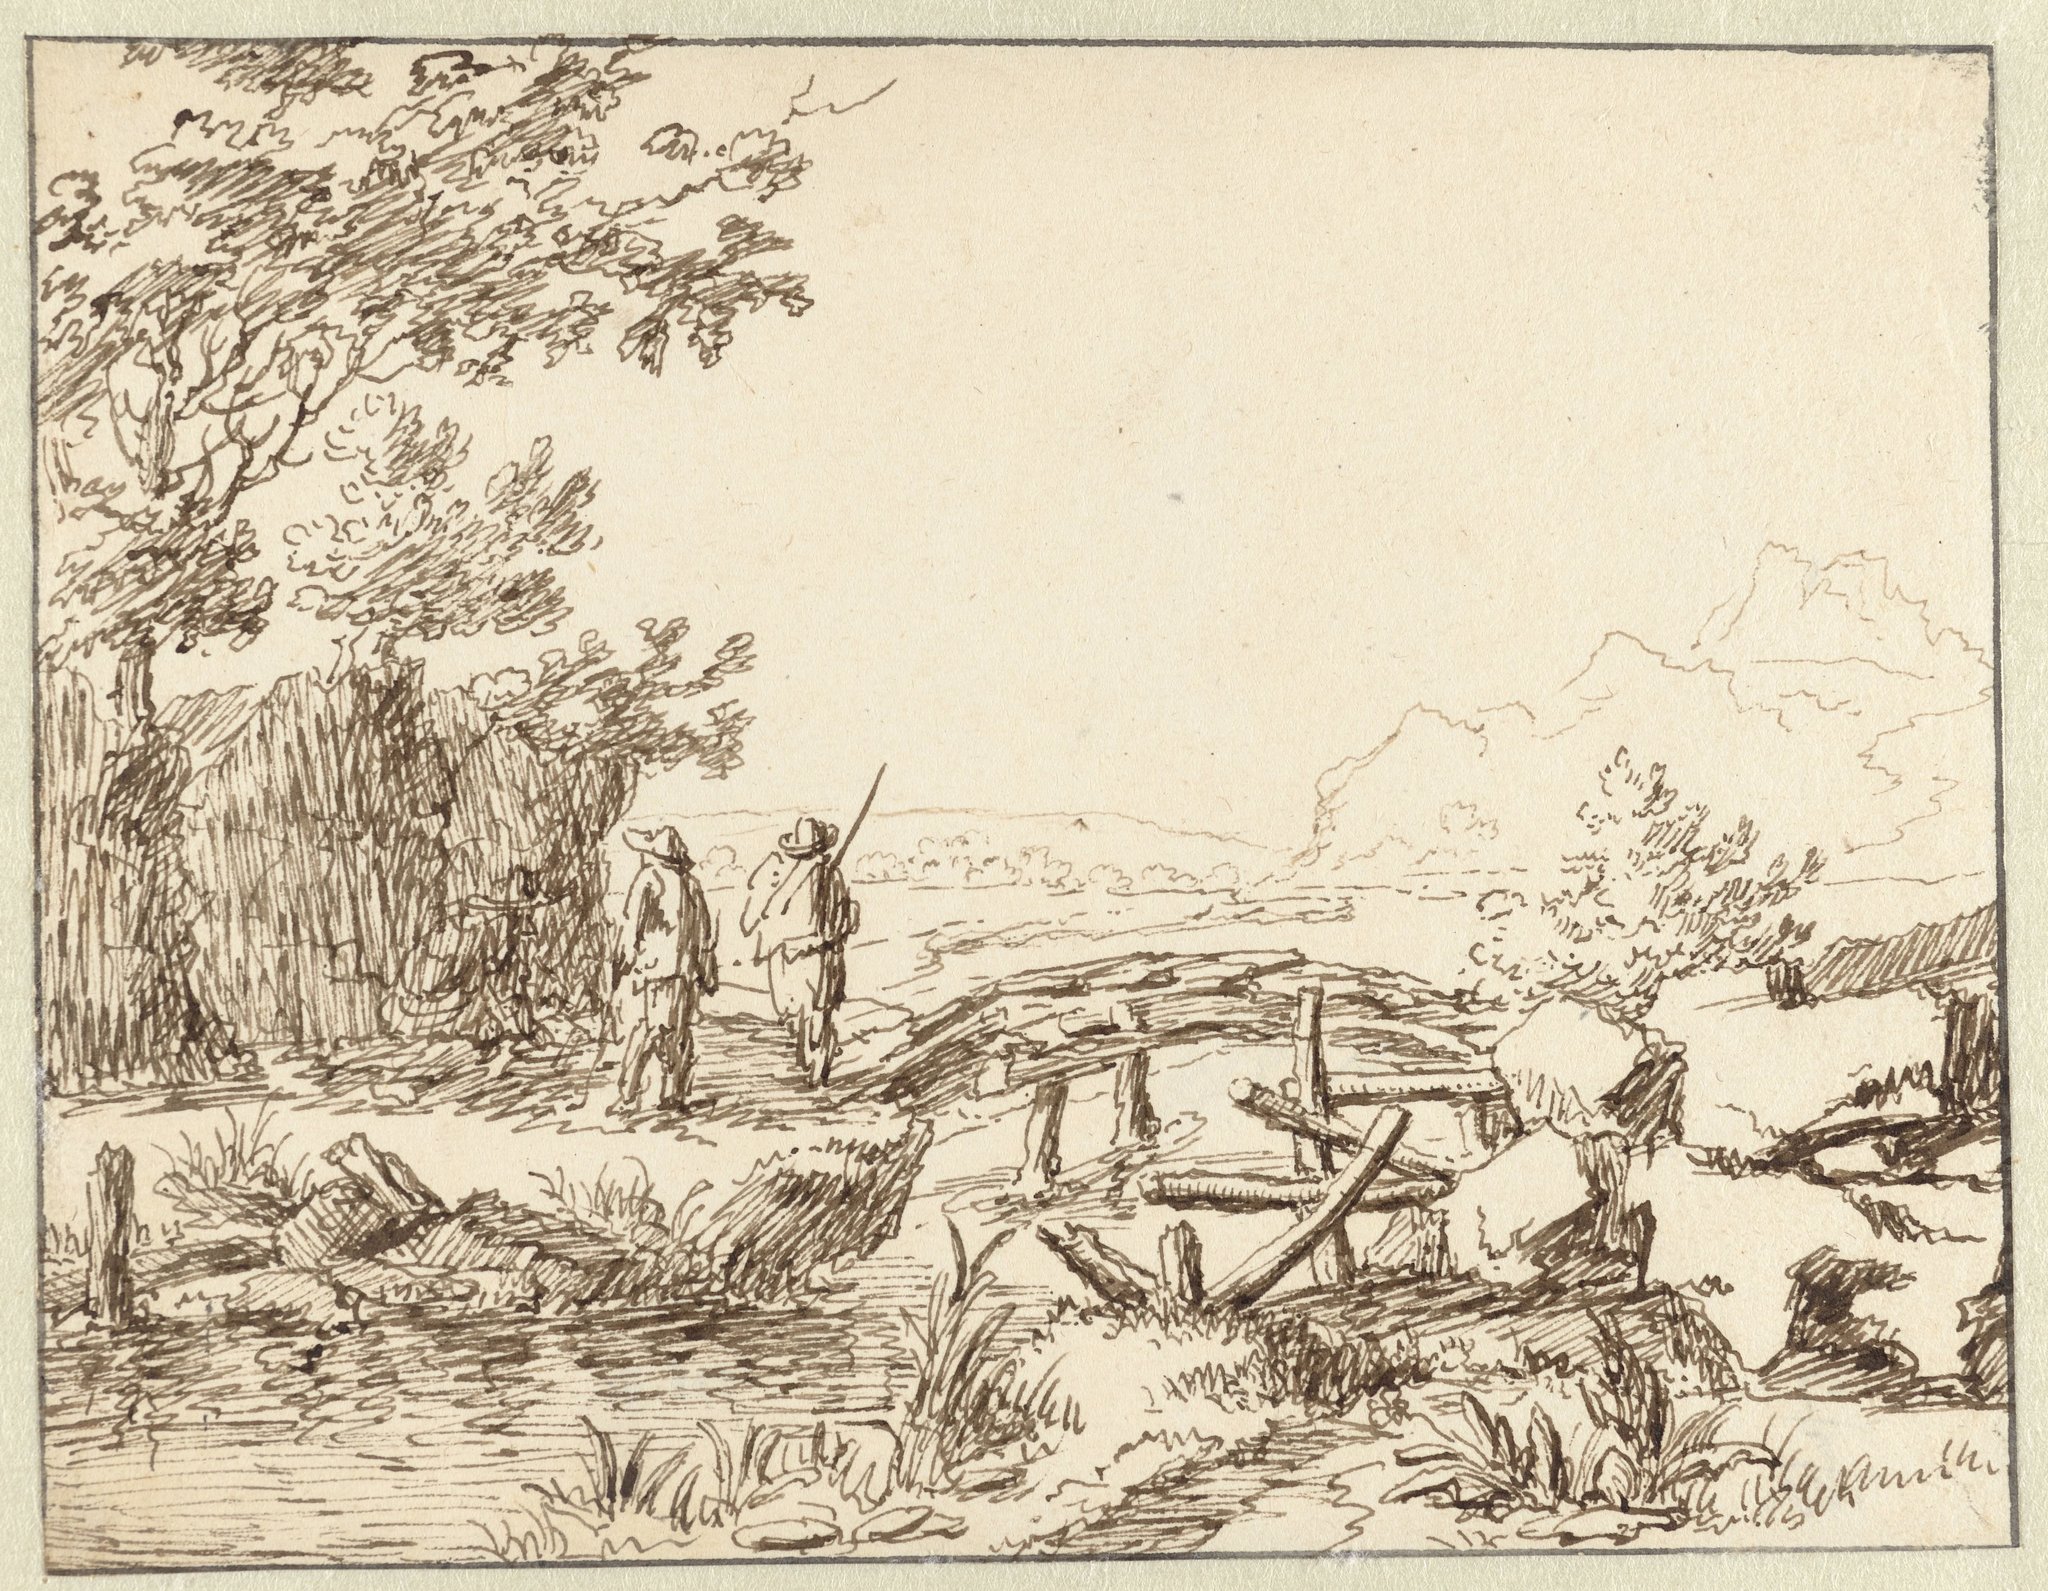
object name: drawing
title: Drie mannen bij een brug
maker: jan van almeloveen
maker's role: draughtsman, print maker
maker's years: 1652-1683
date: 1682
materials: ink, paper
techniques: pen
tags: landscape with bridge, viaduct or aqueduct (+ city(-scape) with figures, staffage)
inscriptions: date: ‘27/5/1682’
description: Landschap met een brug over een beek en drie mannen.